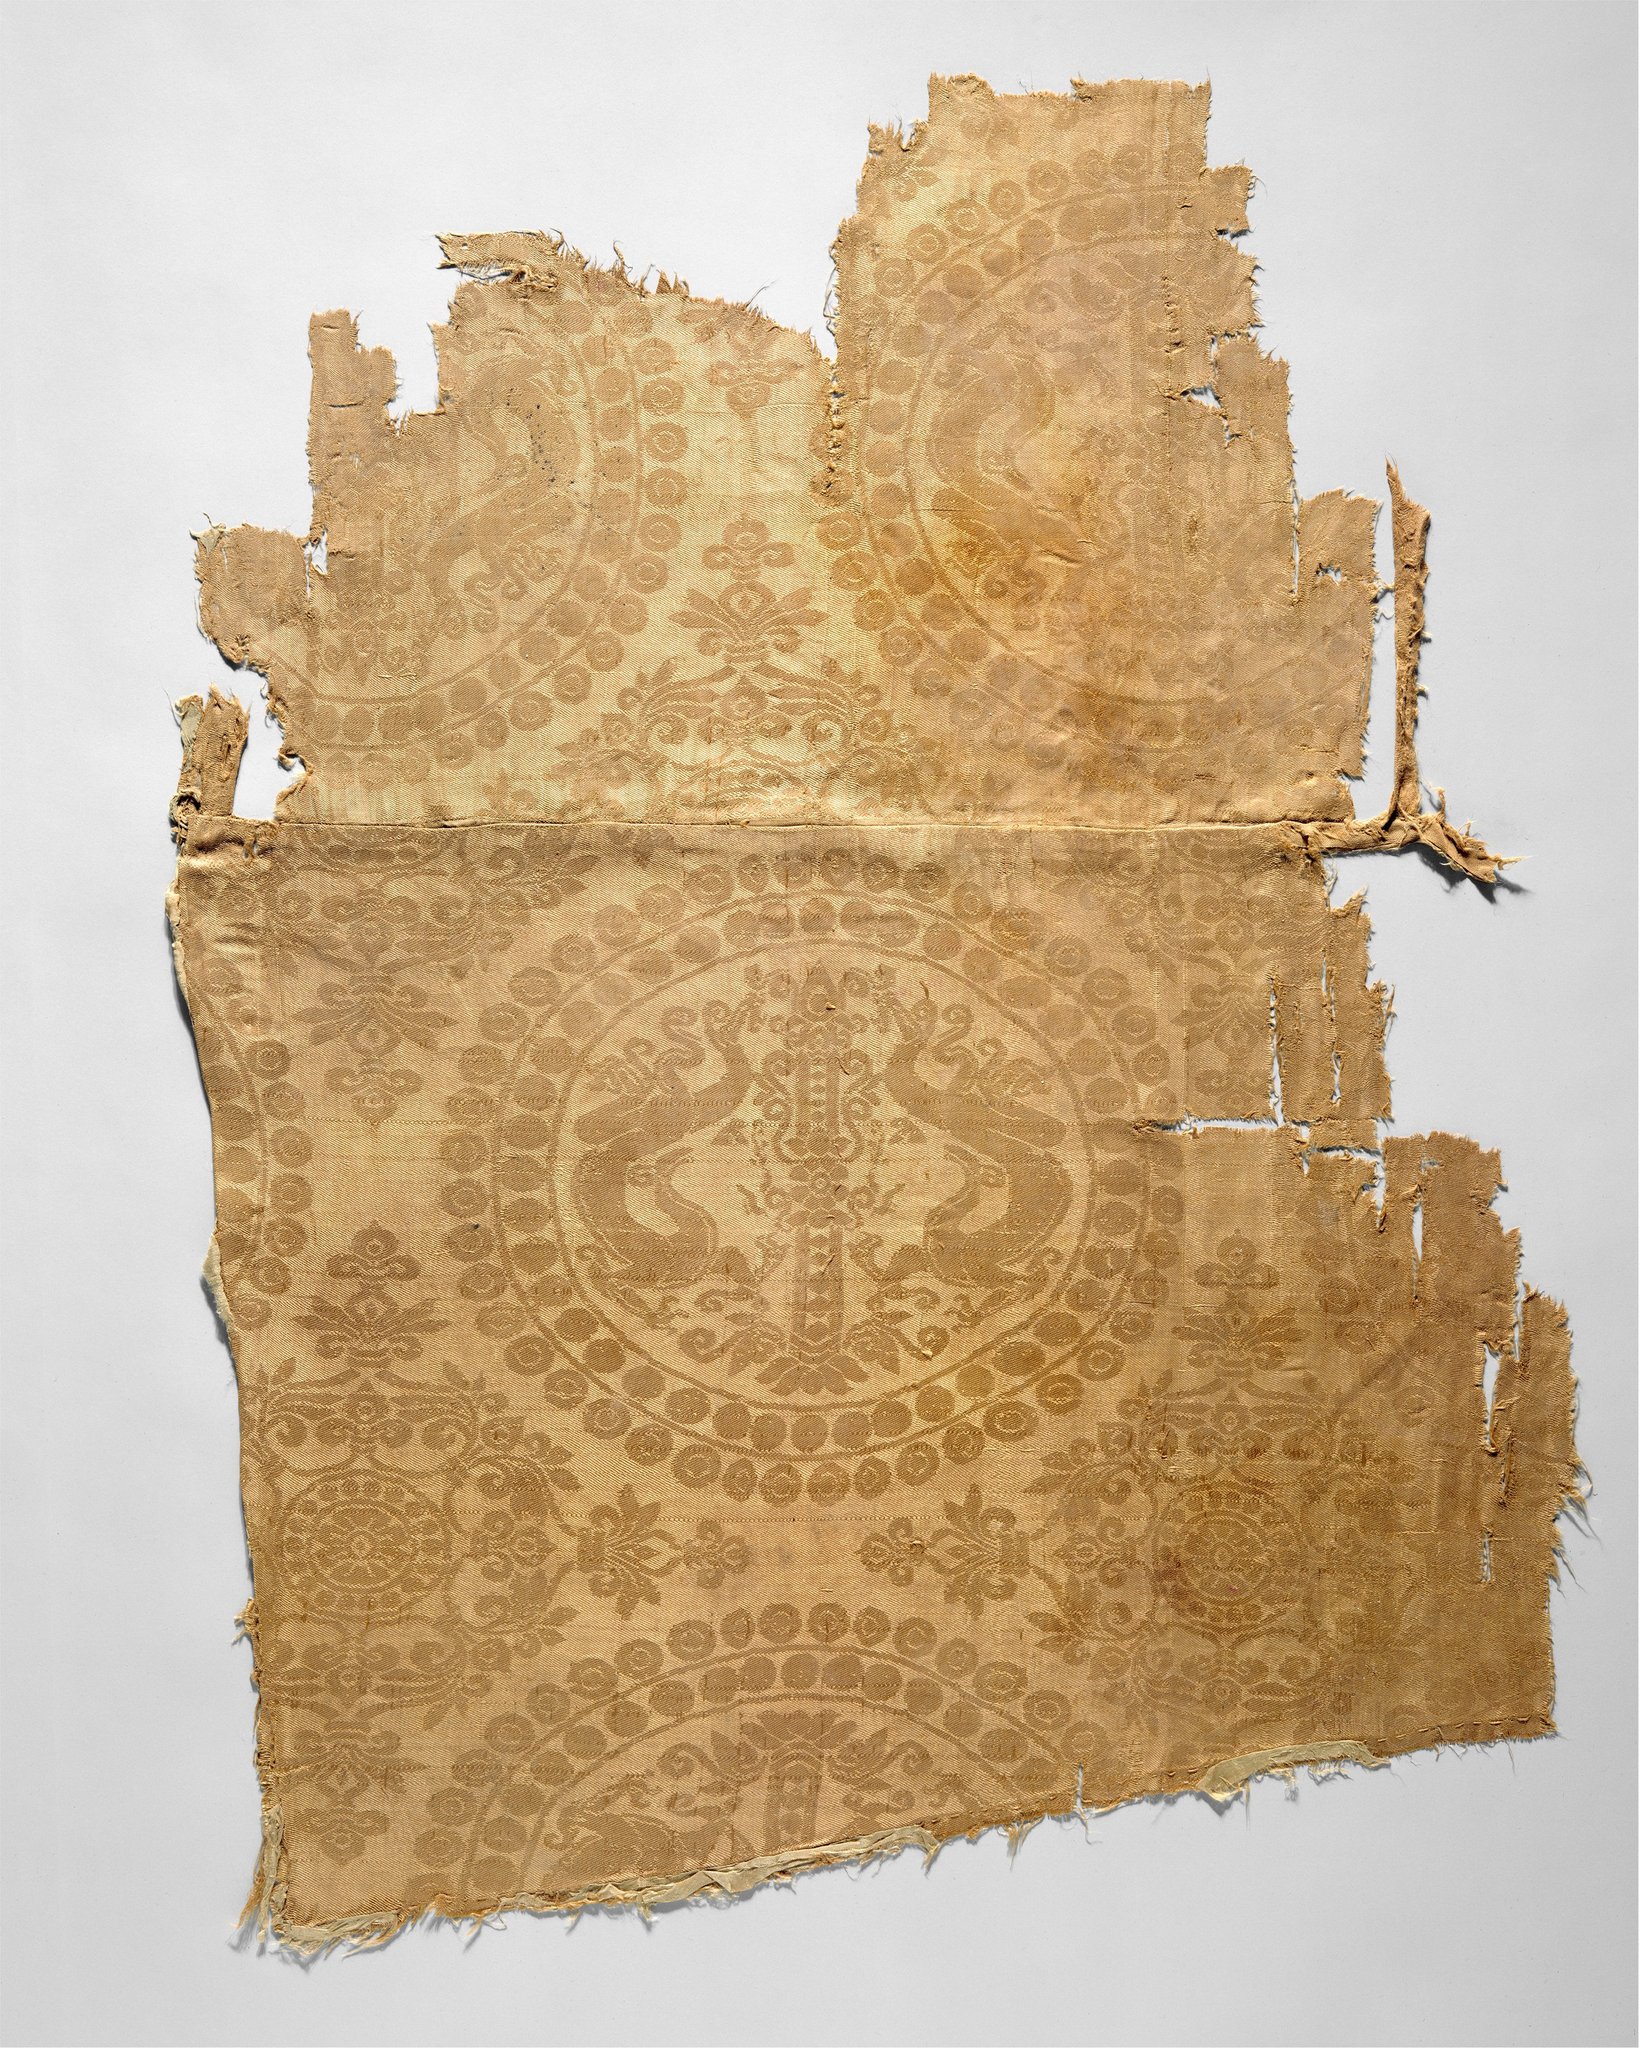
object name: textile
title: Textile with Pearl Roundels with Dragons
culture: chinese or central asian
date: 767-900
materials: silk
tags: dragons